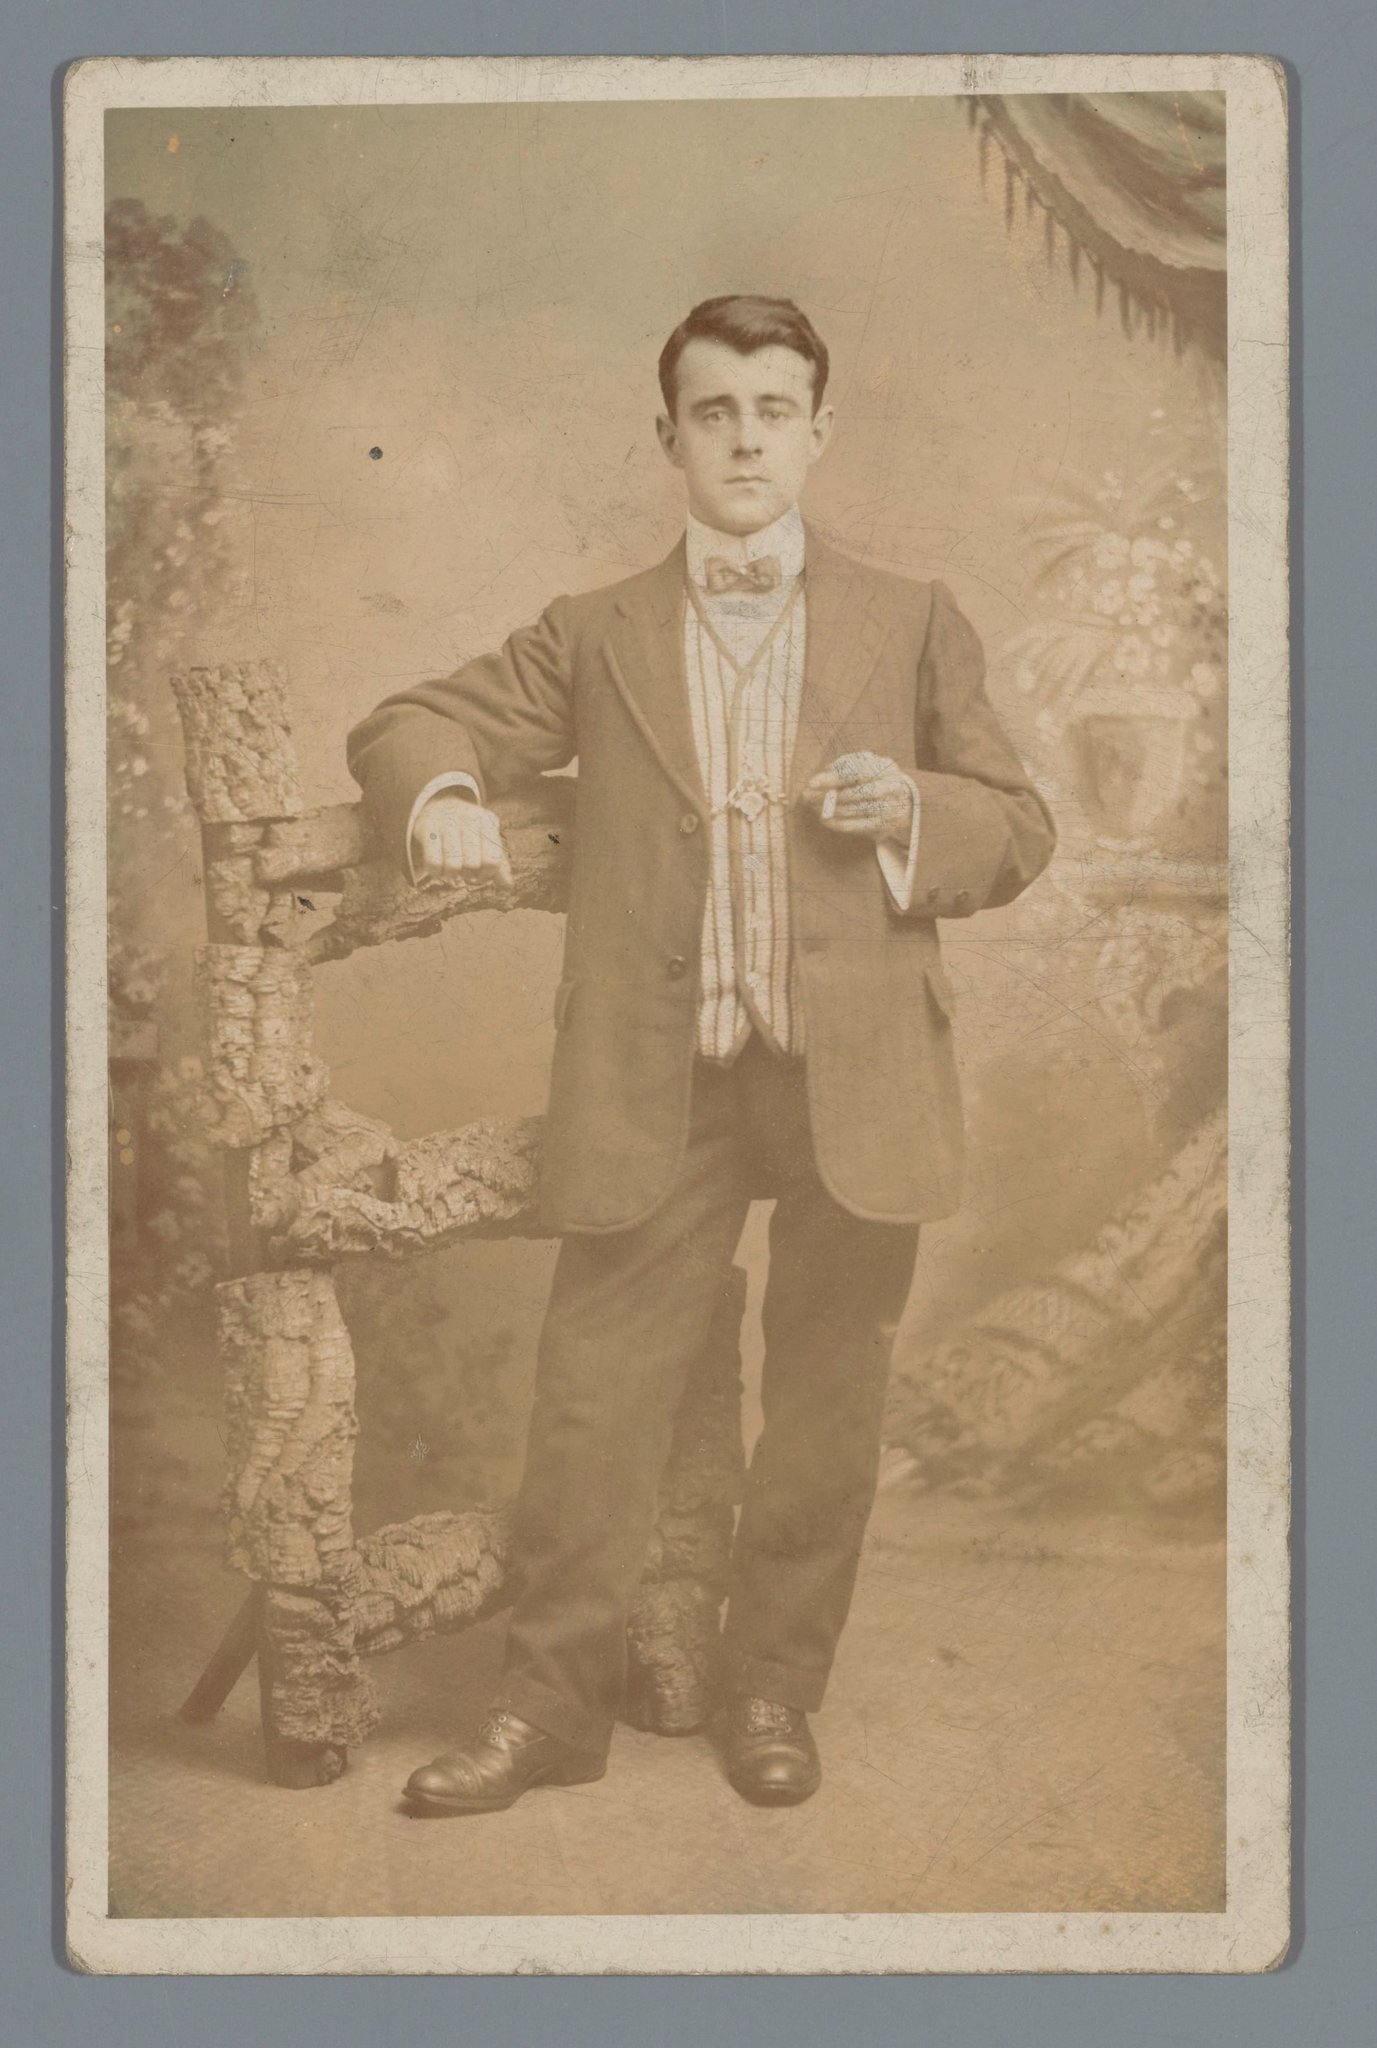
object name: photograph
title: Studioportret van een onbekende man met een sigaret in de hand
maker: t. brierley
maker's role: fotograaf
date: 1905-1915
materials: photographic support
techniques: gelatin silver print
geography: yorkshire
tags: studio ~ photographer, cigarette, adult man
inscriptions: inscription: ‘T. Brierley. Empire Studio, 108 Yorkshire St. Oldham and 7 Rothwell St., Rochdale’